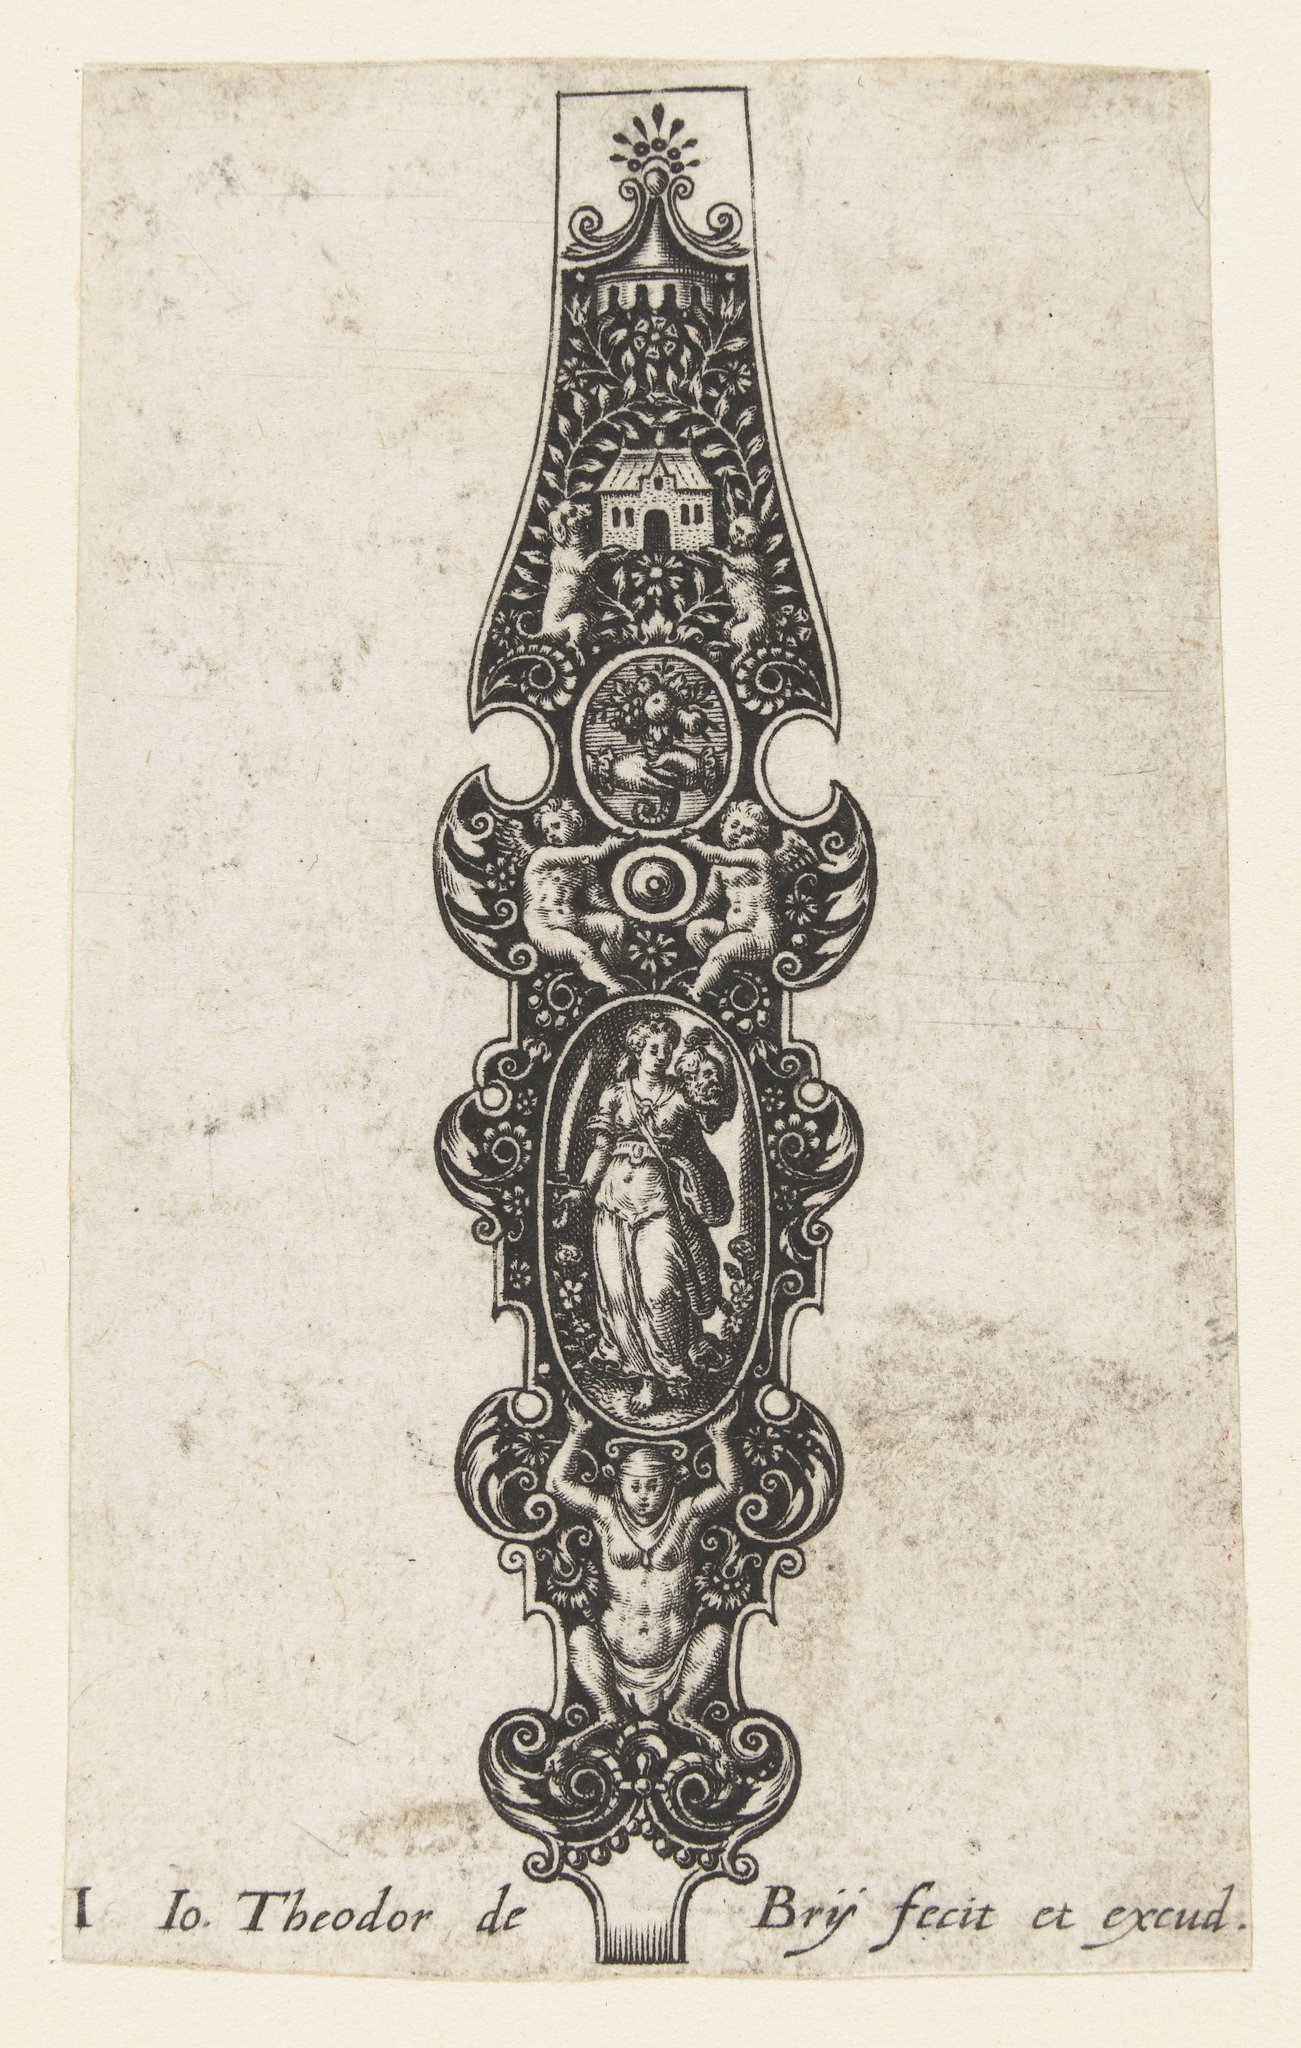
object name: ornament print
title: Sleutelhaak met in het ovaal Judith met het hoofd van Holofernes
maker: johann theodor de bry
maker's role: print maker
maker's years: 1561-1623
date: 1598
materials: paper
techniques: engraving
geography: germany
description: Onderaan hurkt een vrouwelijke sater. Bovenaan zitten een hond en een konijn ter weerszijden van een huis. Hoort bij serie van 5 bladen.